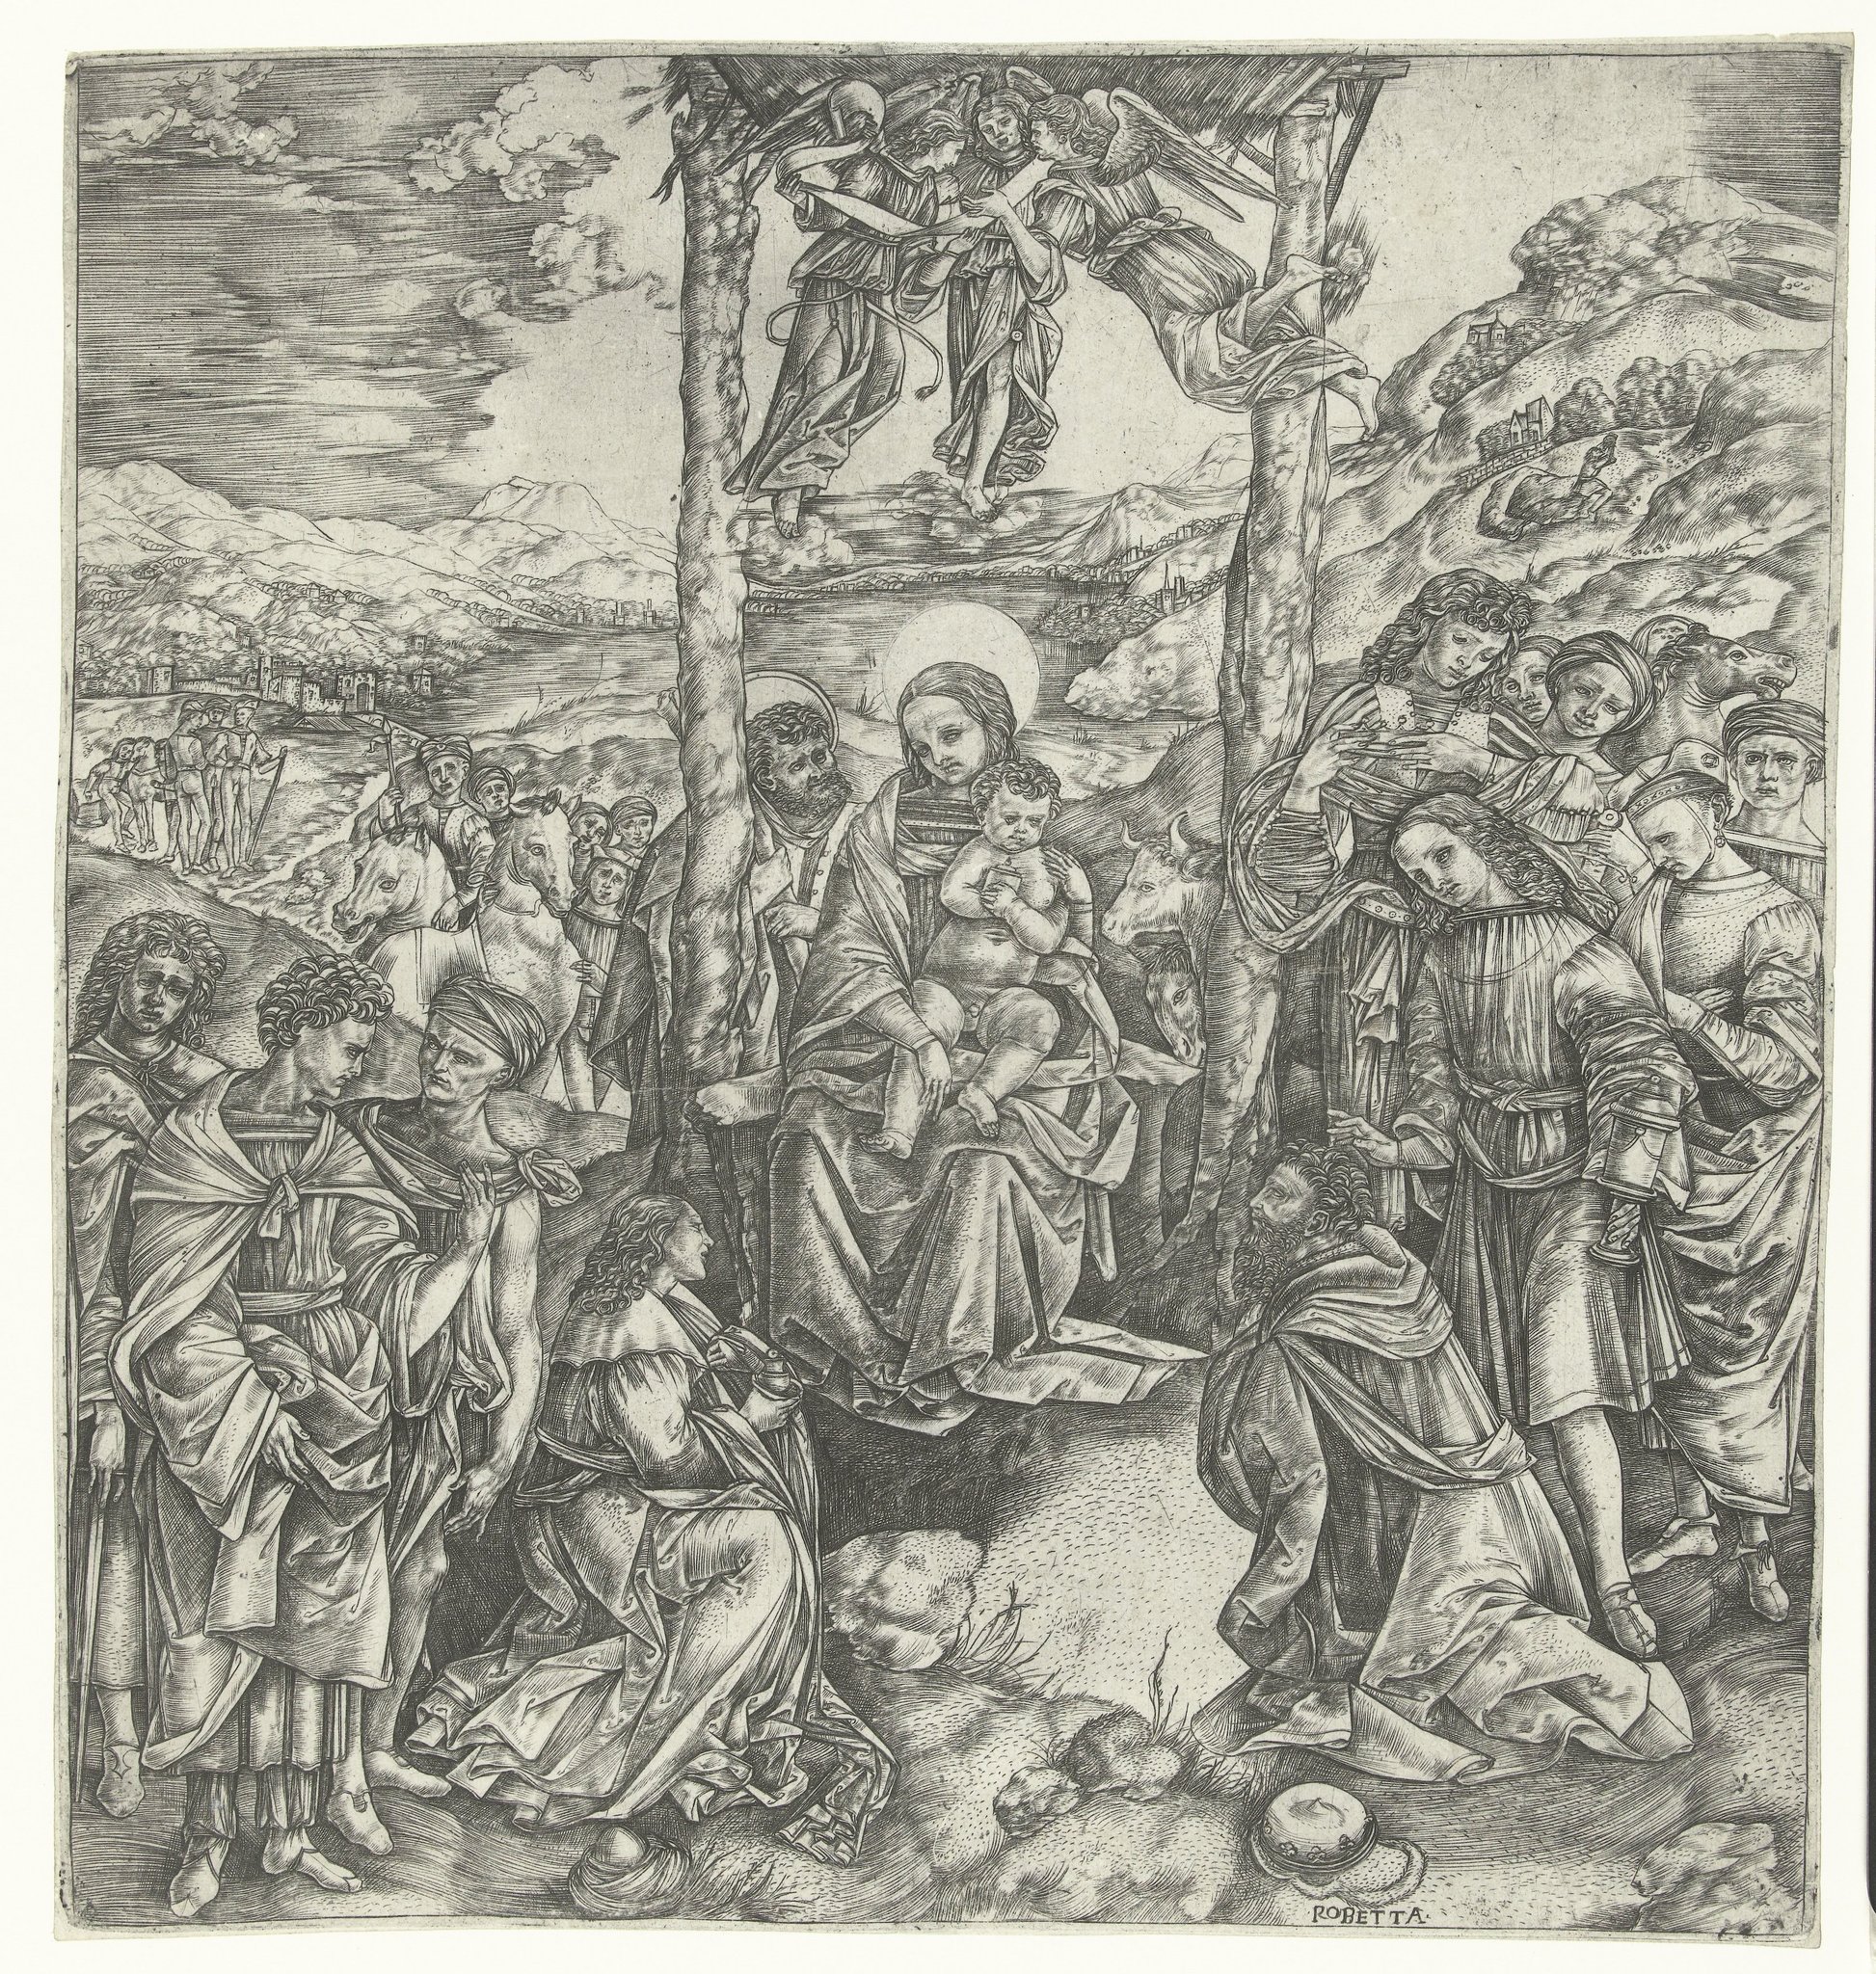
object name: print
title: Aanbidding van de koningen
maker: christoforo di michele robetta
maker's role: print maker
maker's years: 1462-1522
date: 1510-1515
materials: paper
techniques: engraving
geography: italy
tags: adoration of the kings: the wise men present their gifts to the christ-child (gold, frankincense and myrrh)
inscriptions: collector's mark: Lugt 2231, collector's mark: Lugt 2760, collector's mark: Lugt 2166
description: De kunstenaar heeft zich gebaseerd op een schilderij van Filippino Lippi maar heeft wel grote aanpassingen gemaakt. De verbeelding van het onderwerp sluit geheel aan bij de beeldtraditie in de late vijftiende eeuw in Florence (zie documentatie).